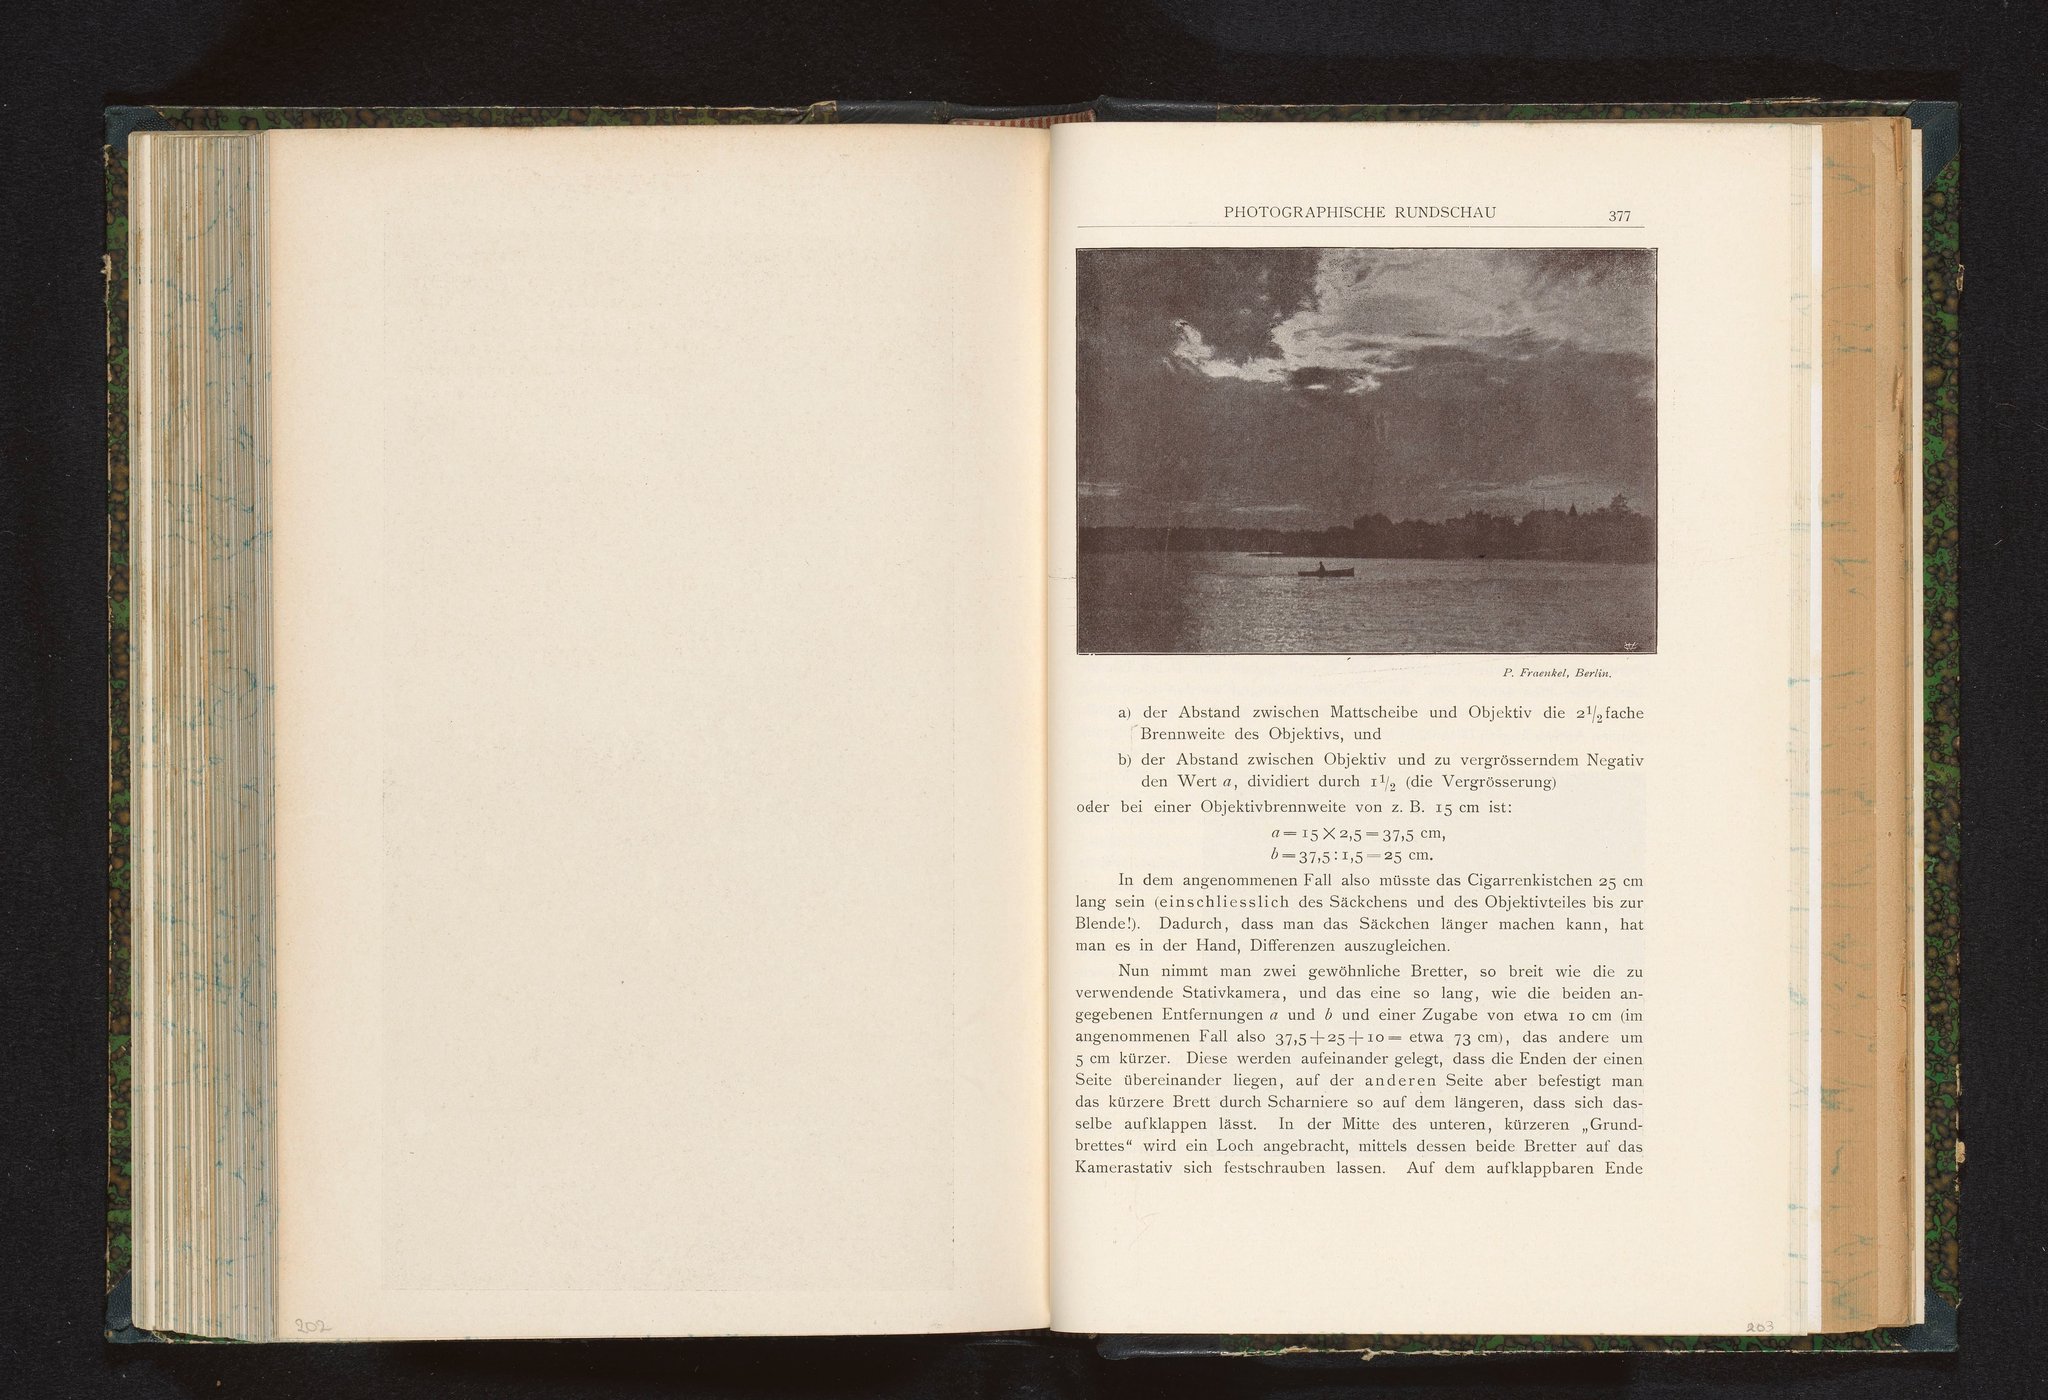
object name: photomechanical print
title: Boot op open water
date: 1894-1899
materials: paper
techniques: autotype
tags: landscapes with waters, waterscapes, seascapes (in the temperate zone), rowing-boat, canoe, etc.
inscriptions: monogram: ‘CW’